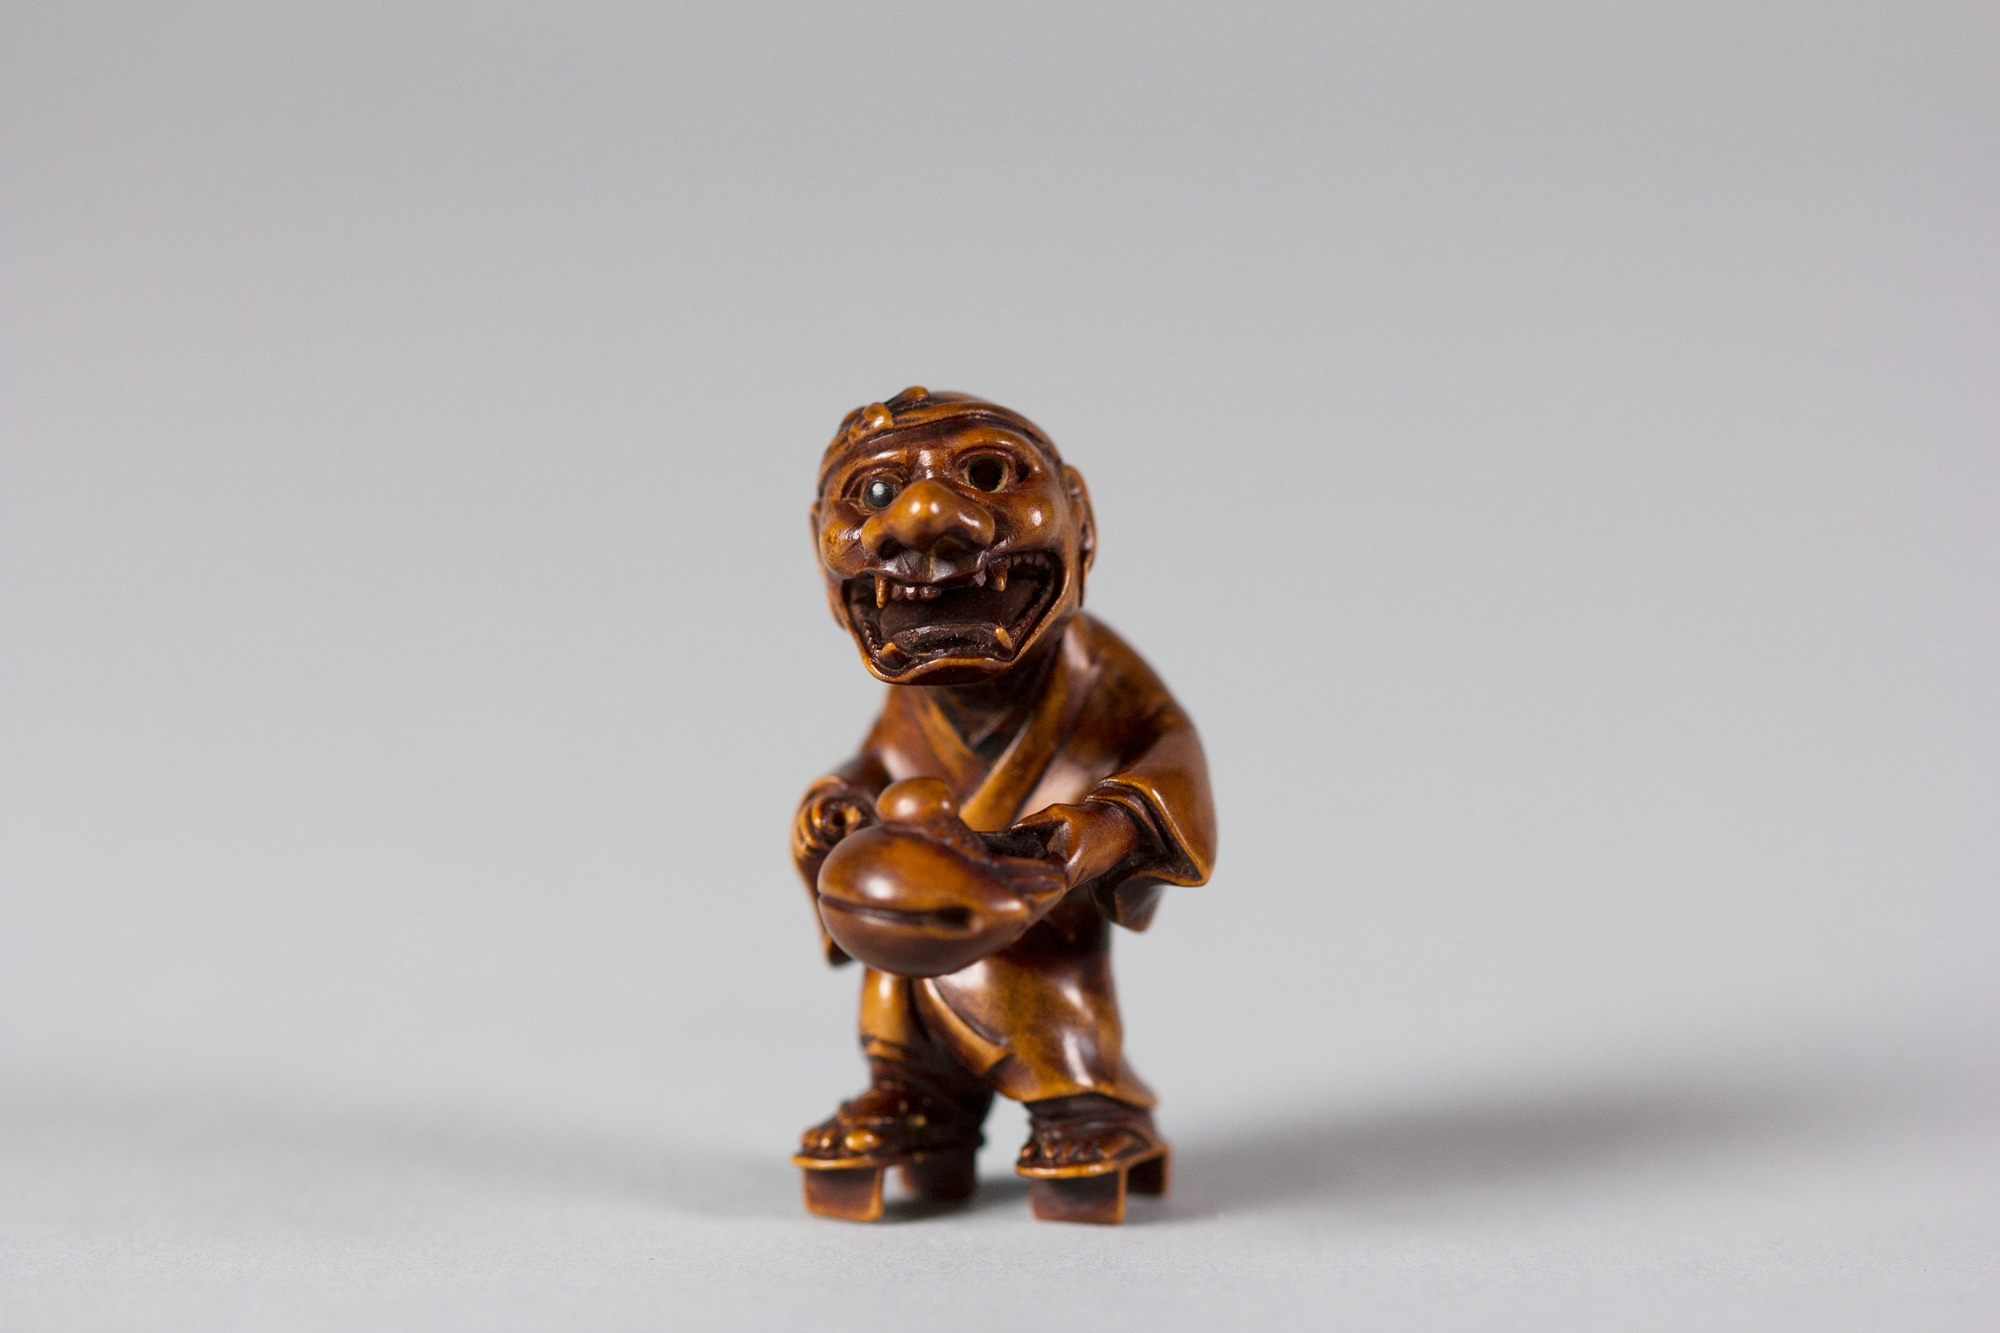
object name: netsuke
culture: japanese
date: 1801-1900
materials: wood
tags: men